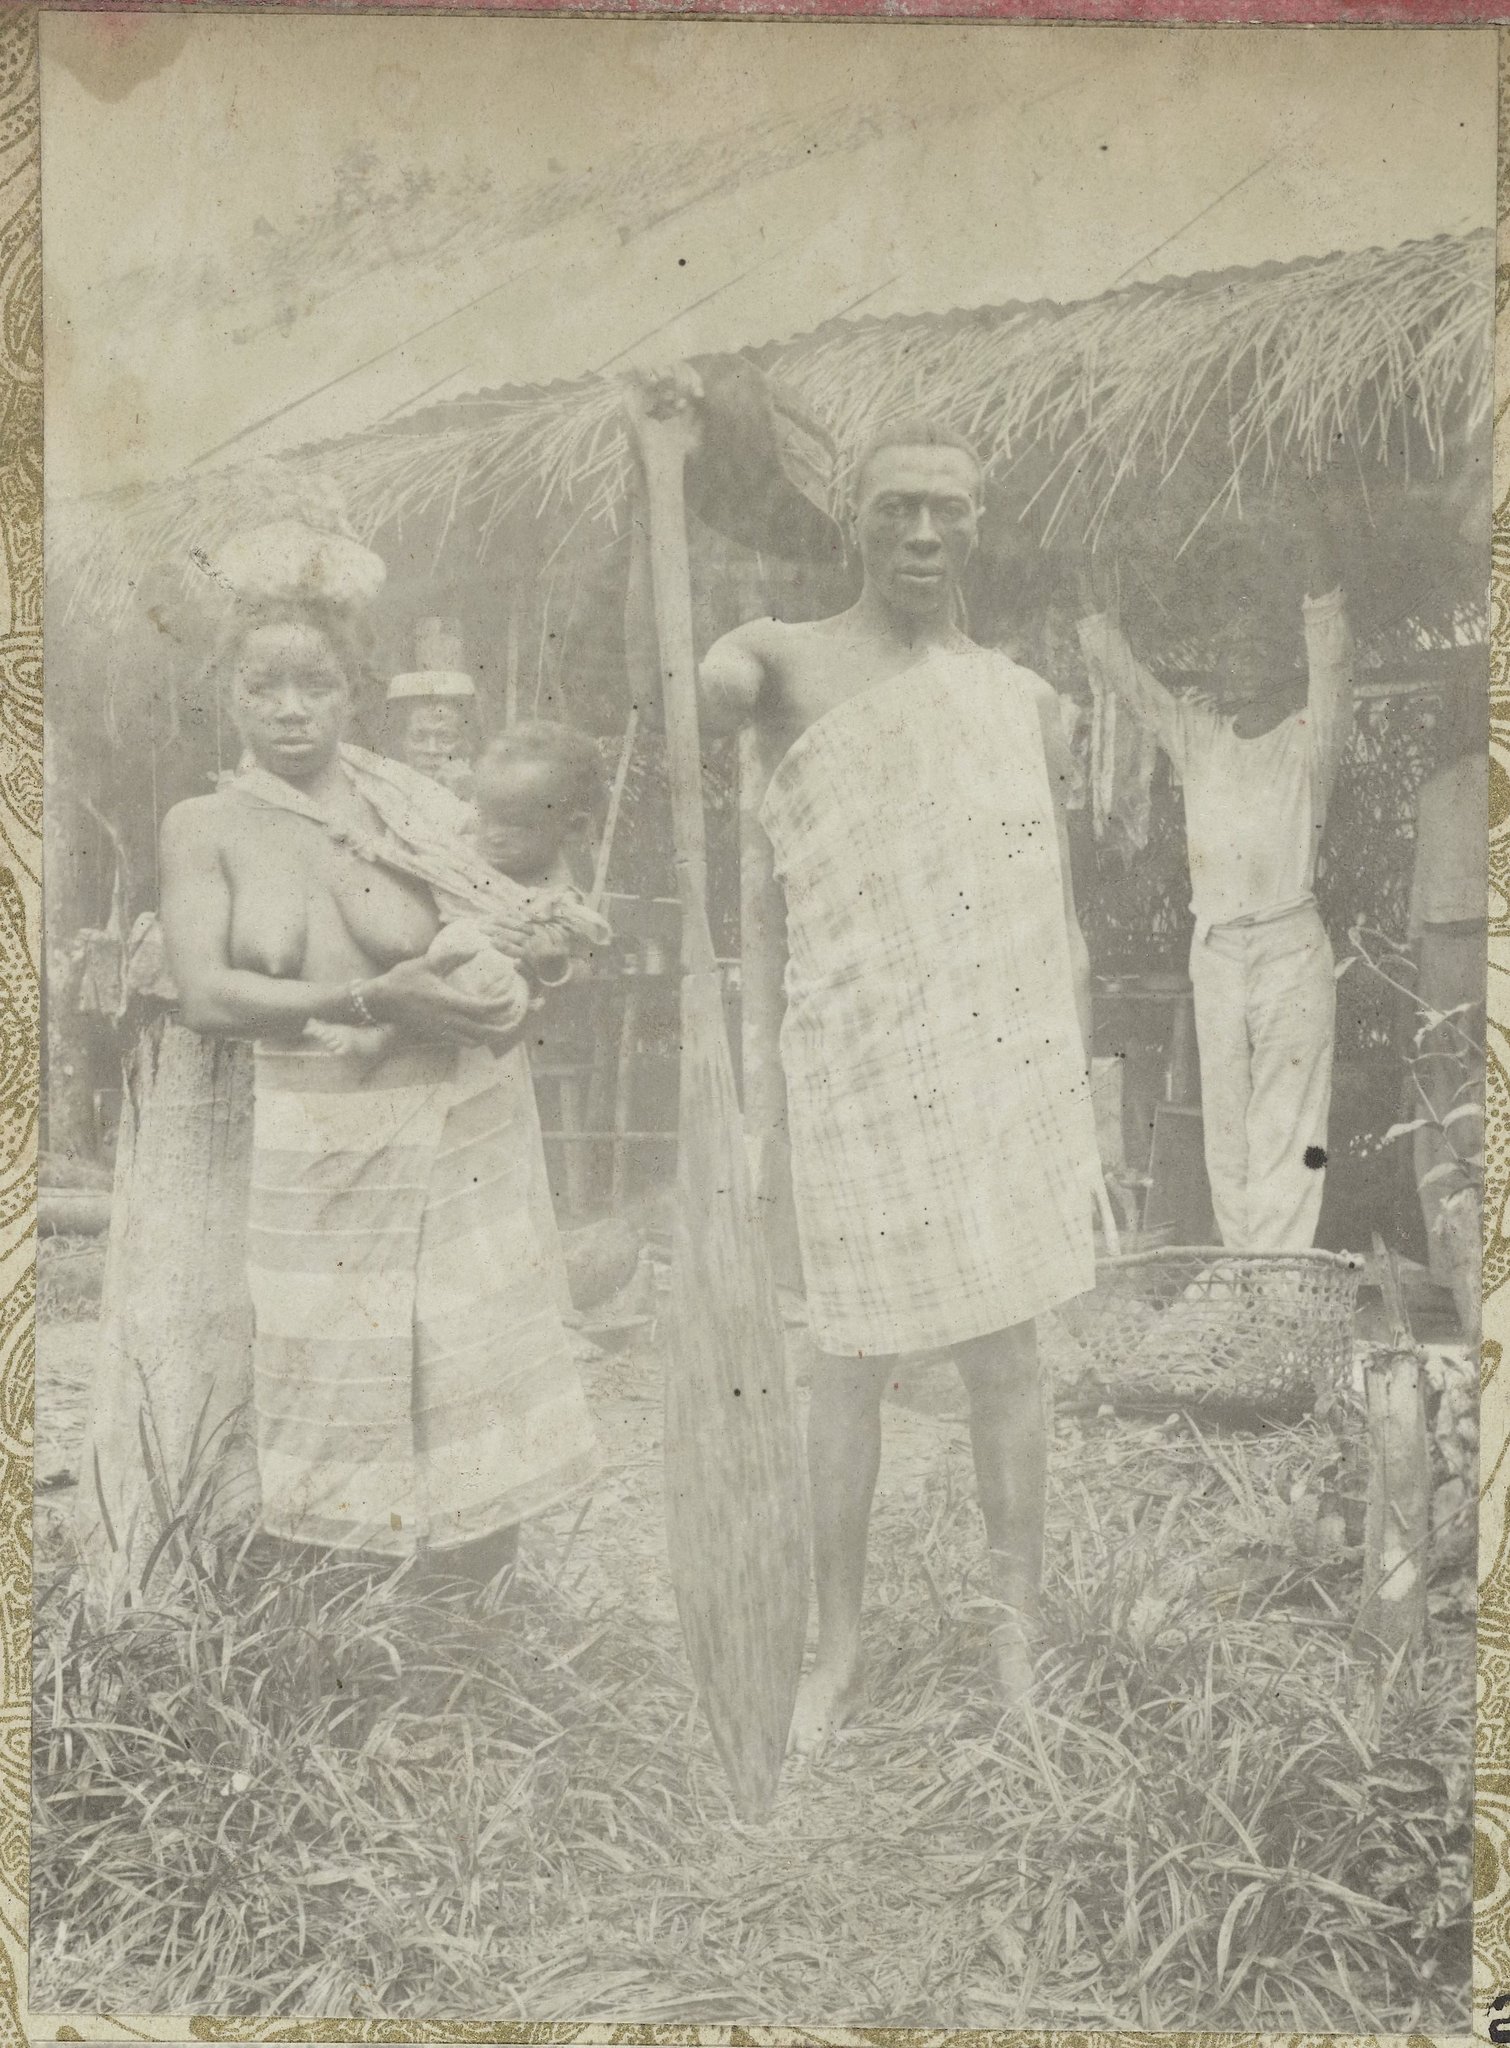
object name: photograph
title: Marrongezin uit Gansee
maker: hendrik doijer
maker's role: engineer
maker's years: 1863-1925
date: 1903-1910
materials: photographic support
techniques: gelatin silver print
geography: suriname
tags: suriname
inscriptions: inscription: ‘2’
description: Marron gezin uit het dorp Gansee staande voor een huis te Kwakoegron, de man houdt zijn hand op een houten roeispaan. Onderdeel van het fotoalbum Souvenir de Voyage (deel 1), over het leven van de familie Doijer in en rond de plantage Ma Retraite in Suriname in de jaren 1903-1910.